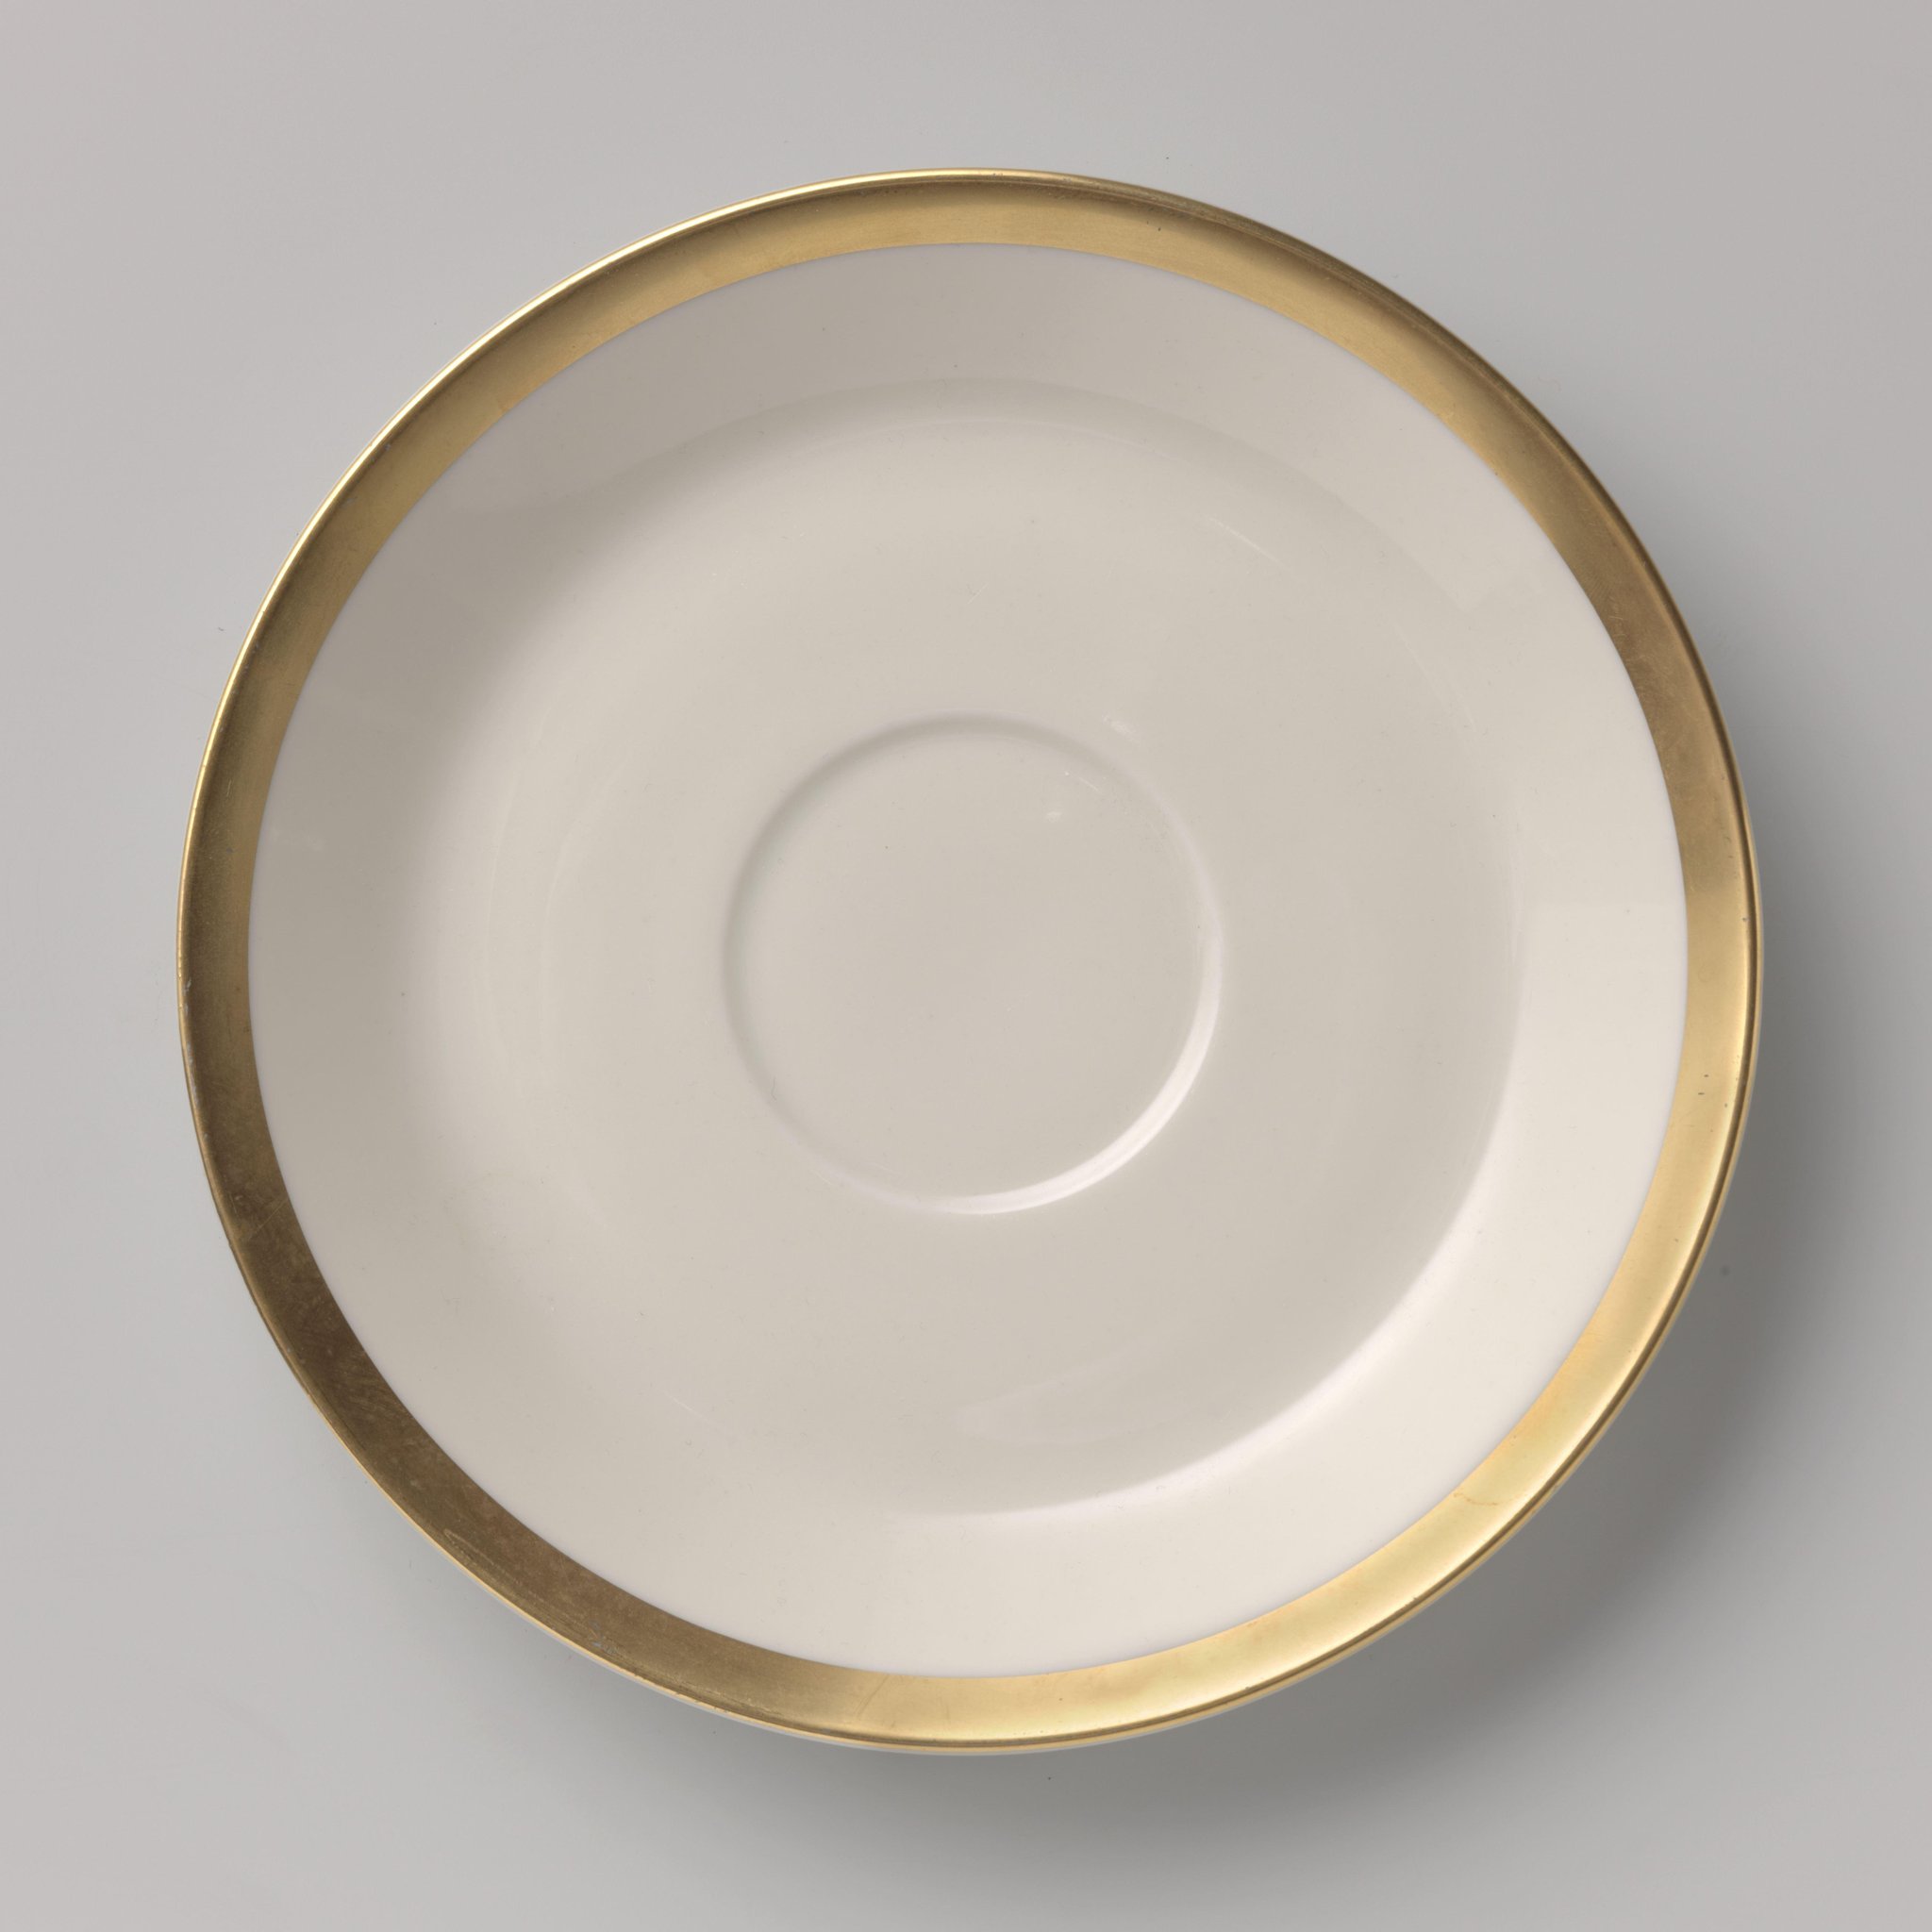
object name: platter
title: Dish used in the House of Representatives of the Netherlands at official receptions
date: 1900-1974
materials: glaze, gold, paint, porcelain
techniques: firing, forming, vitrification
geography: the hague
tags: rotterdam, brussels, the hague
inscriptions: mark: ‘Hutschenreuther Selb/ leeuw met L.H.S. Germany/ Noblesse/ P.A.W. Philippona Den Haag’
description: Schotel van servies gebruikt bij Tweede Kamer der Staten Generaal bij officiële ontvangsten. Klein bord van luxe diner-set met gouden randje en het wapen van de Tweede Kamer. Gebruikt bij Tweede Kamer der Staten Generaal bij officiële ontvangsten.